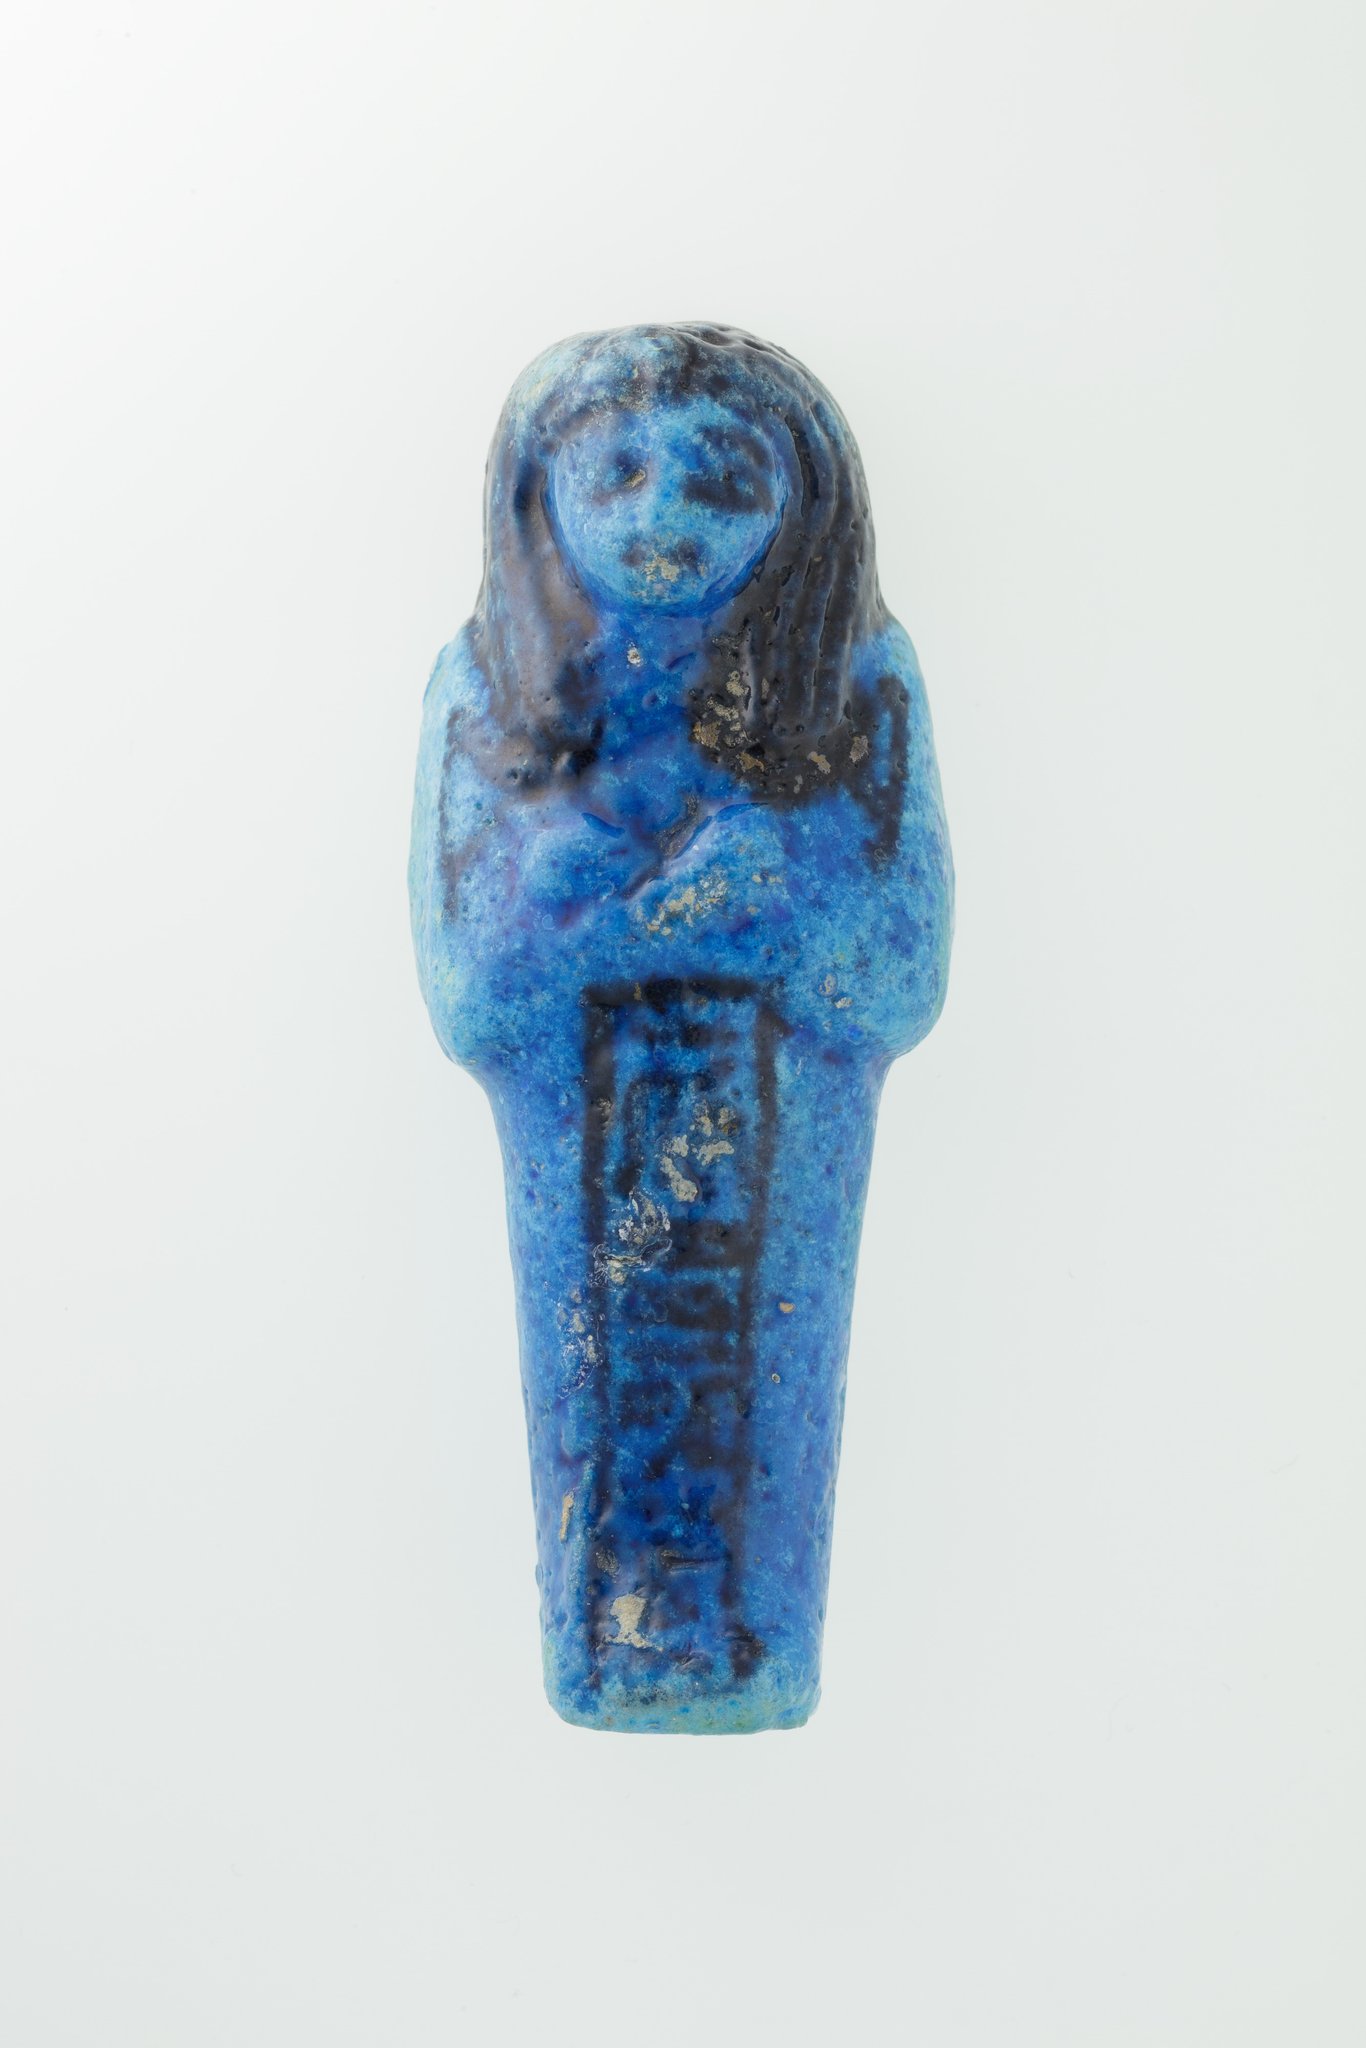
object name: shabti, worker, nauny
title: Worker Shabti of Nauny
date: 1050 BCE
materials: faience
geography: egypt